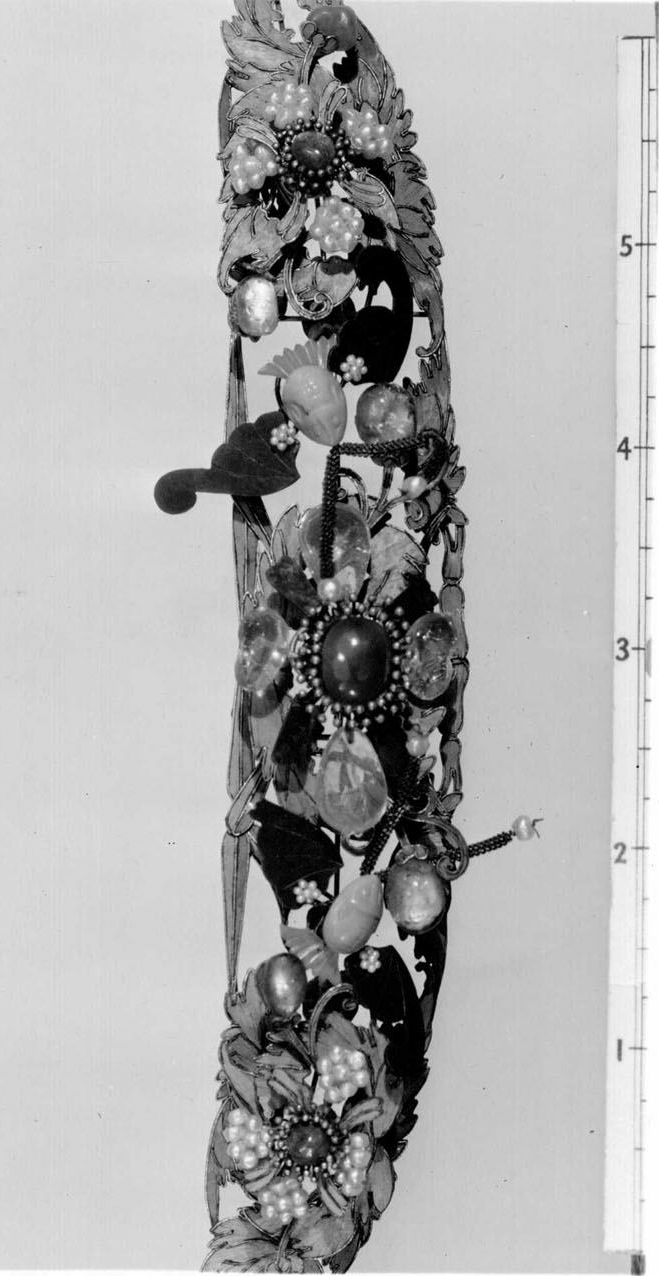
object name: ornament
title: Headdress Ornament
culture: chinese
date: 1701-1900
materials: gemstone, feather, gold, jade, pearl